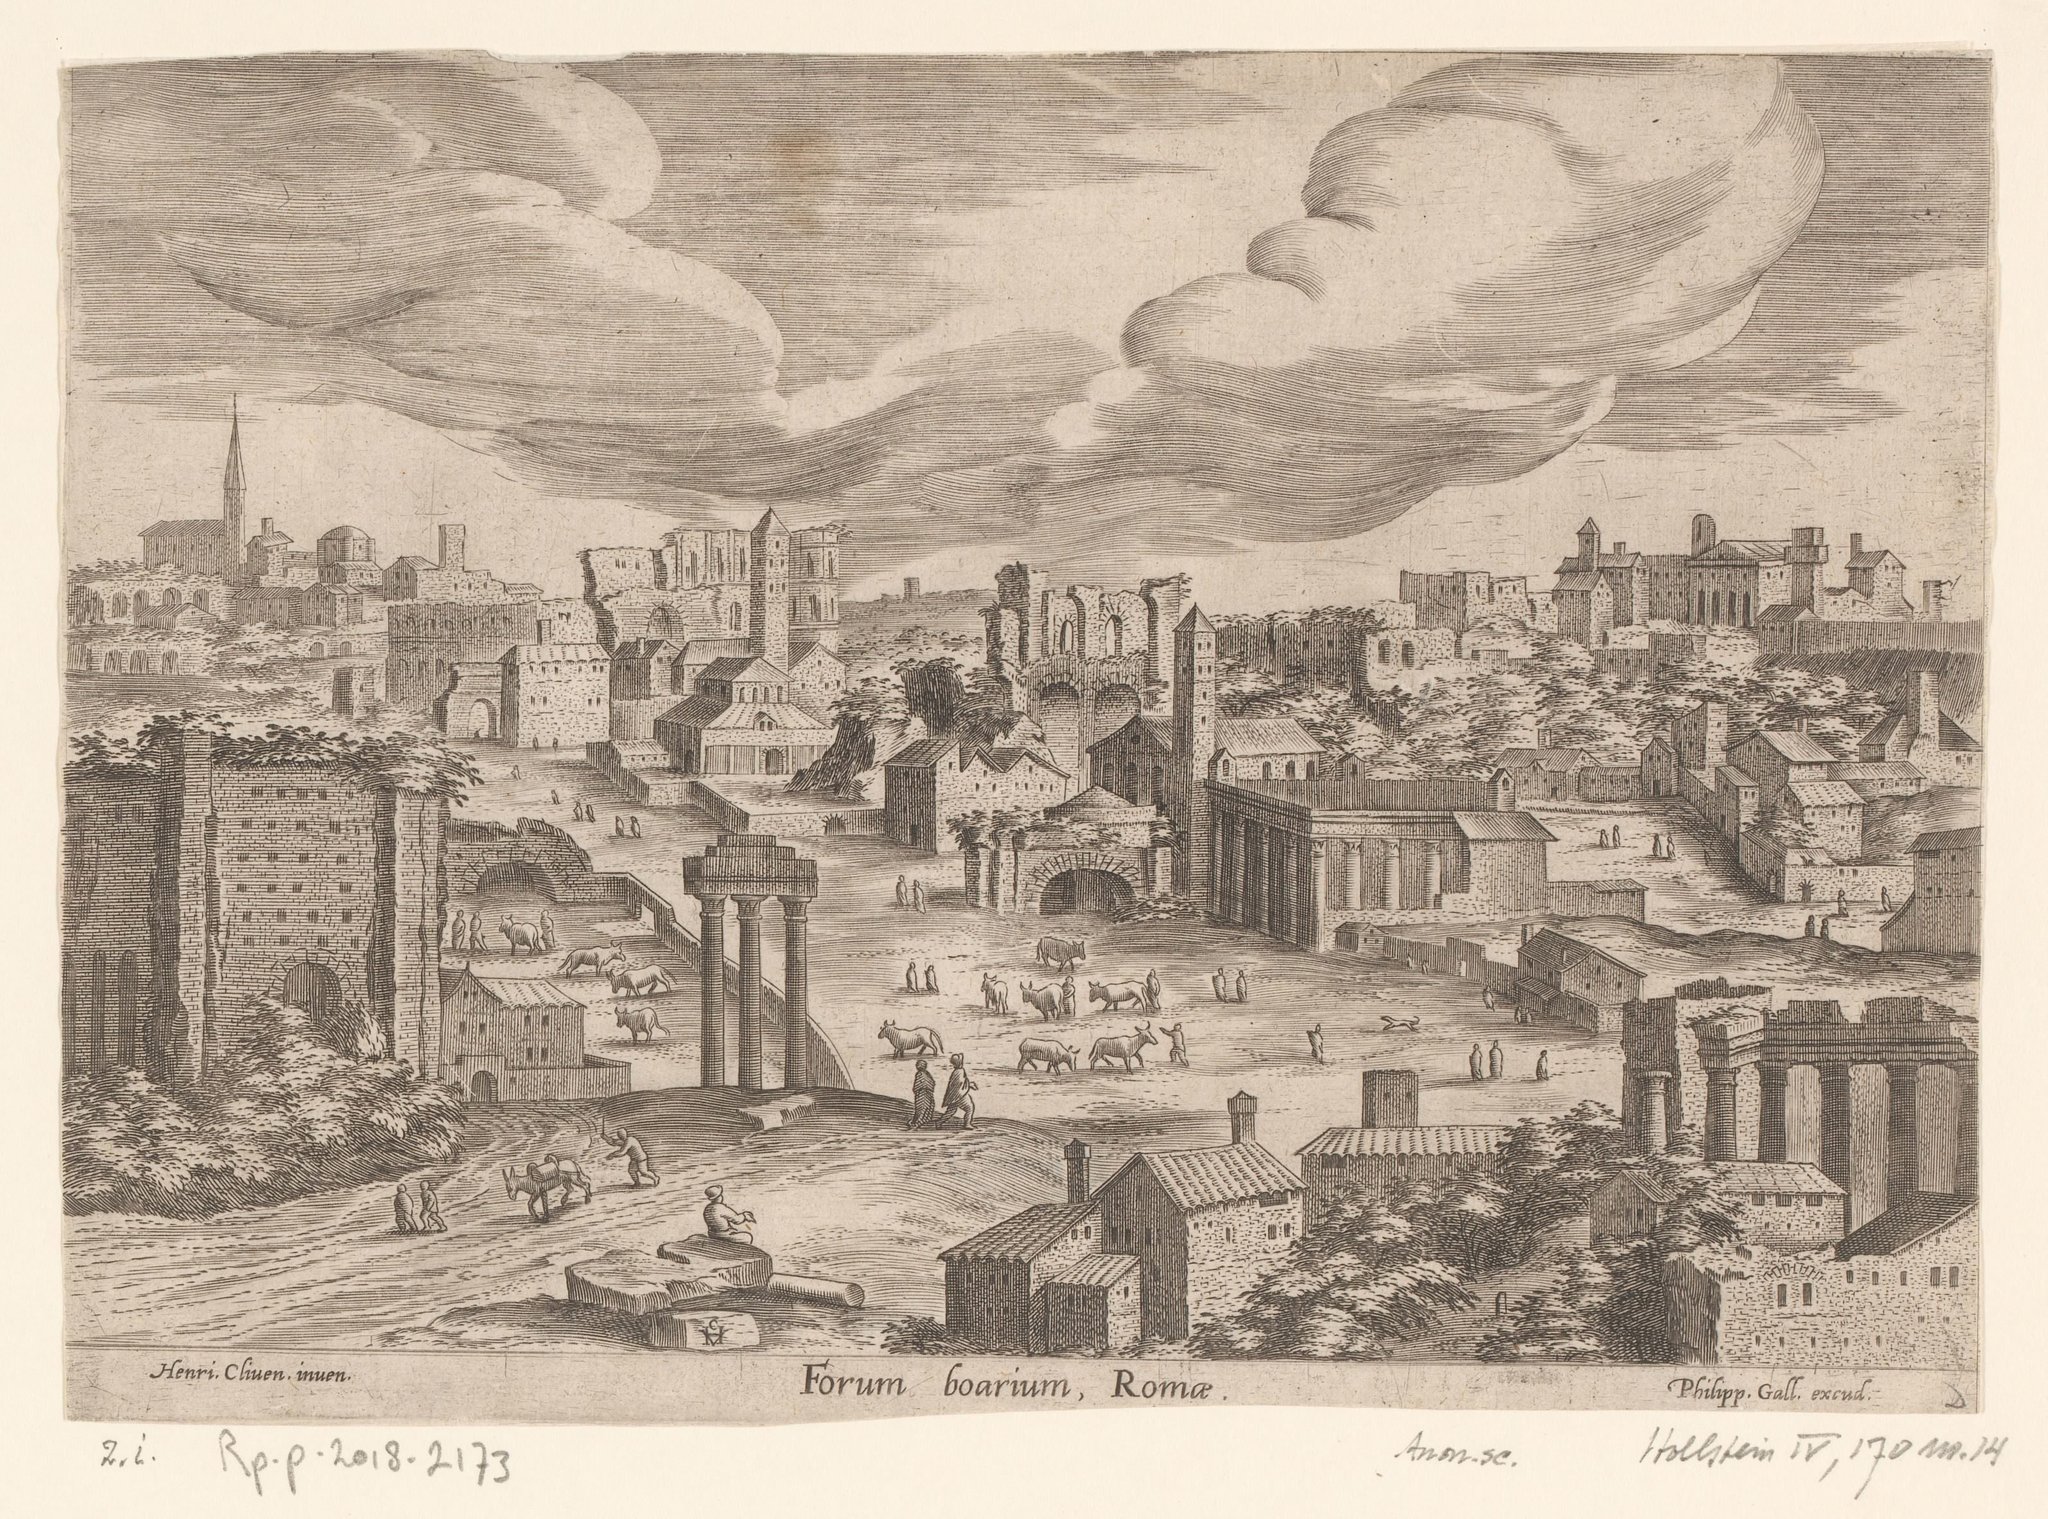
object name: print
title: Ruinarum varii prospectus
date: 1585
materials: paper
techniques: engraving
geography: antwerp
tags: ruin of a building ~ architecture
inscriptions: collector's mark: Lugt 2228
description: Gezicht op de ruïnes van het Forum Boarium, het oudste forum van Rome. Op de voorgrond enkele wandelaars. Op de achtergrond het forum dat in de zestiende eeuw als weide werd gebruikt voor vee. De prent is deel van een serie die verschillende plaatsen in het Middellandse Zeegebied afbeeldt.